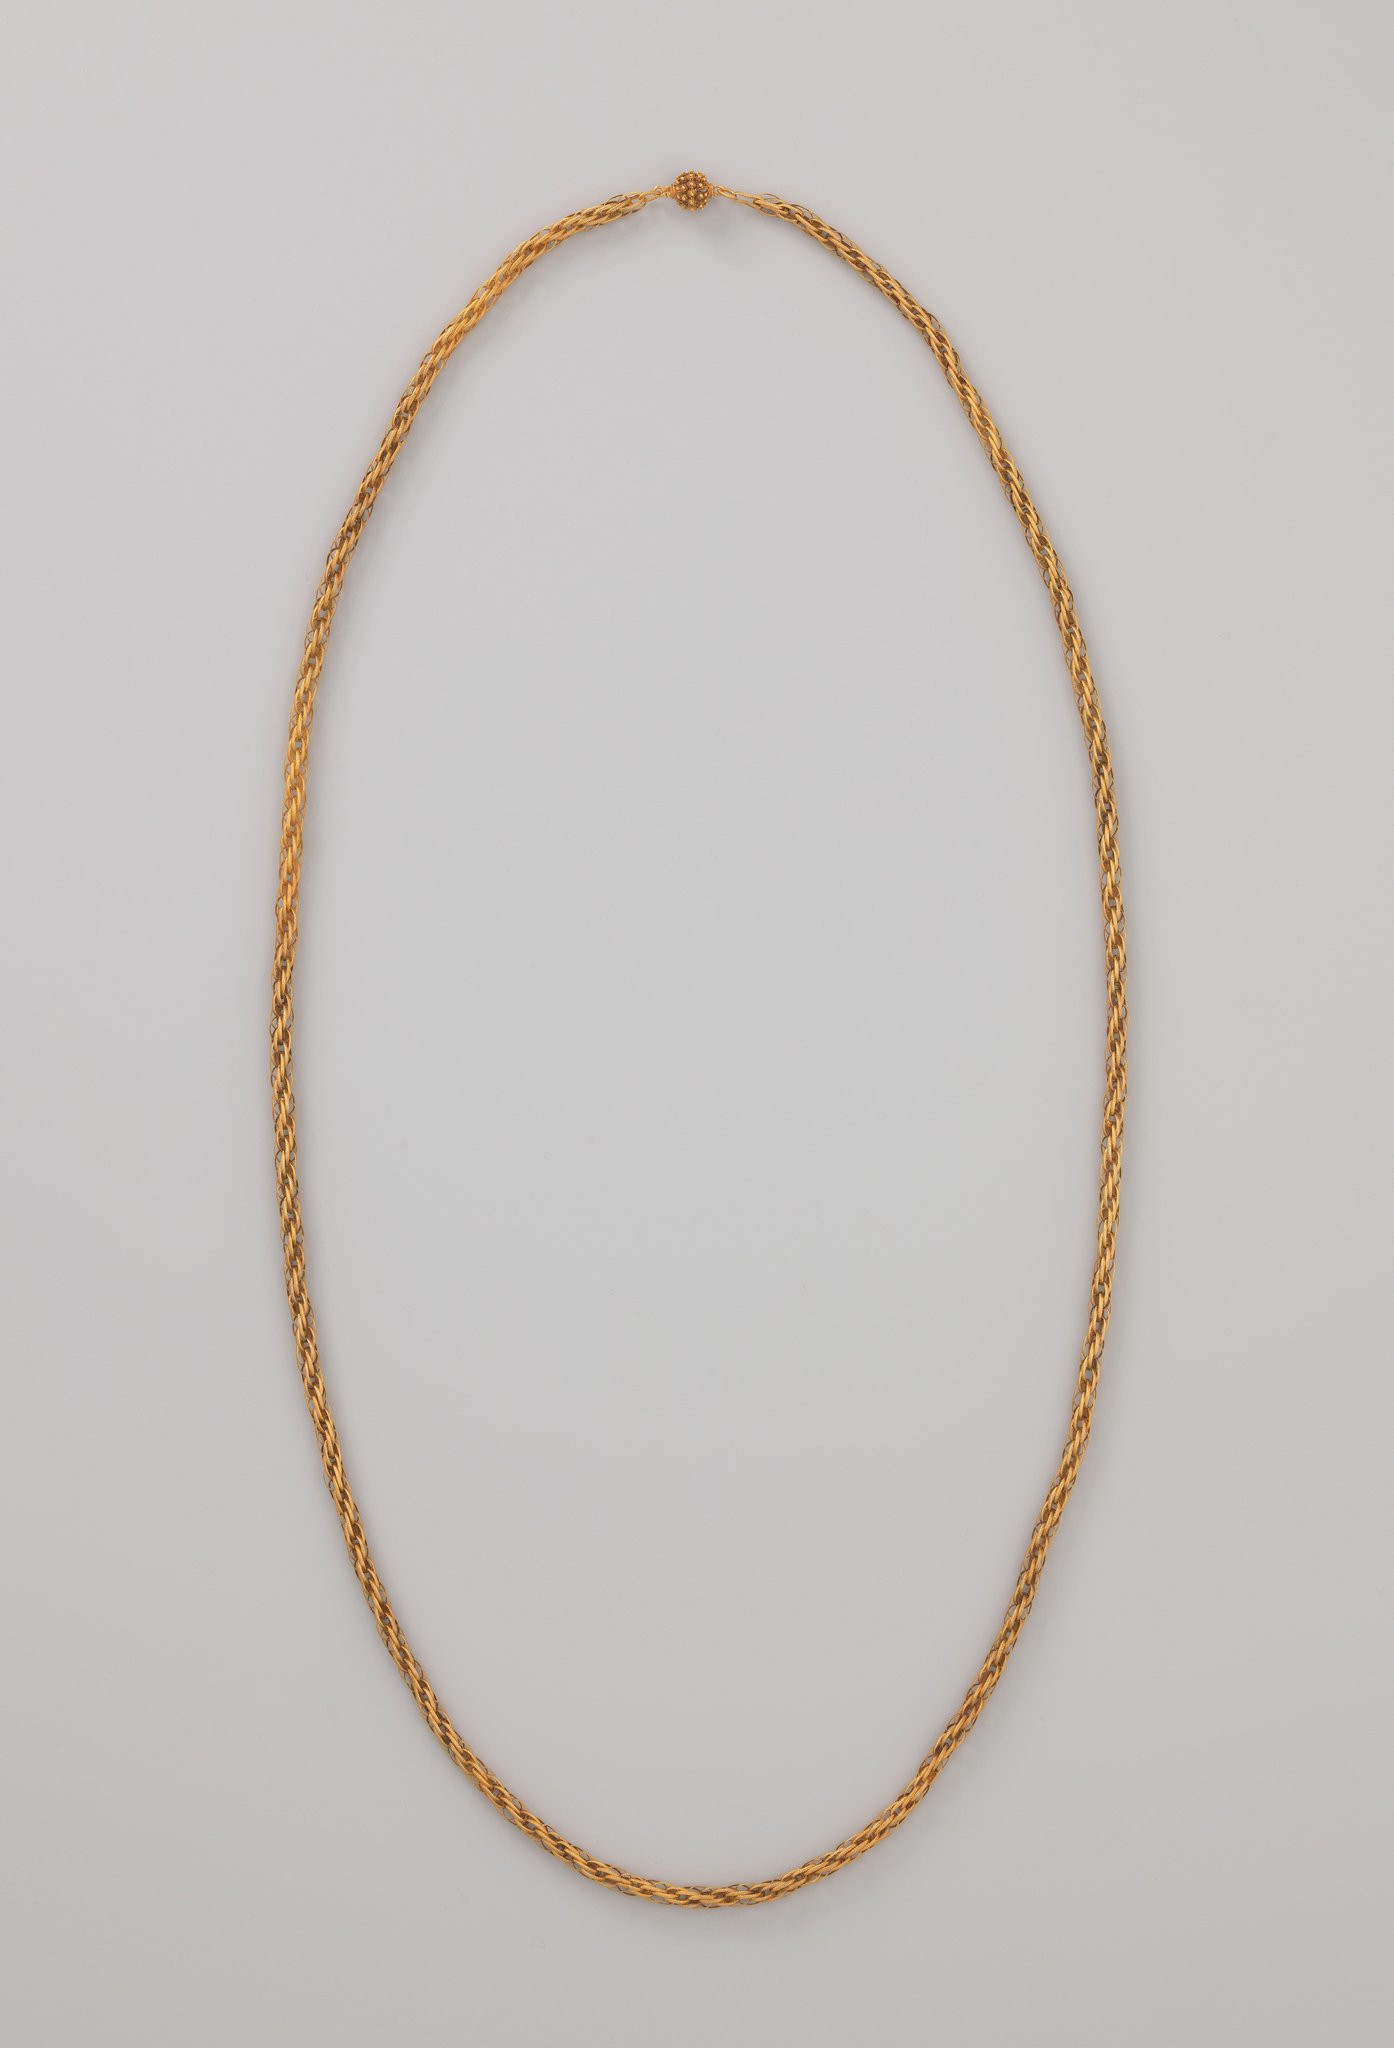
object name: necklace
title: Collier van goud in vossenstaartvorm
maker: johannes mattheus van kempen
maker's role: silversmith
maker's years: 1814-1877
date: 1840-1850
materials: gold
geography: netherlands